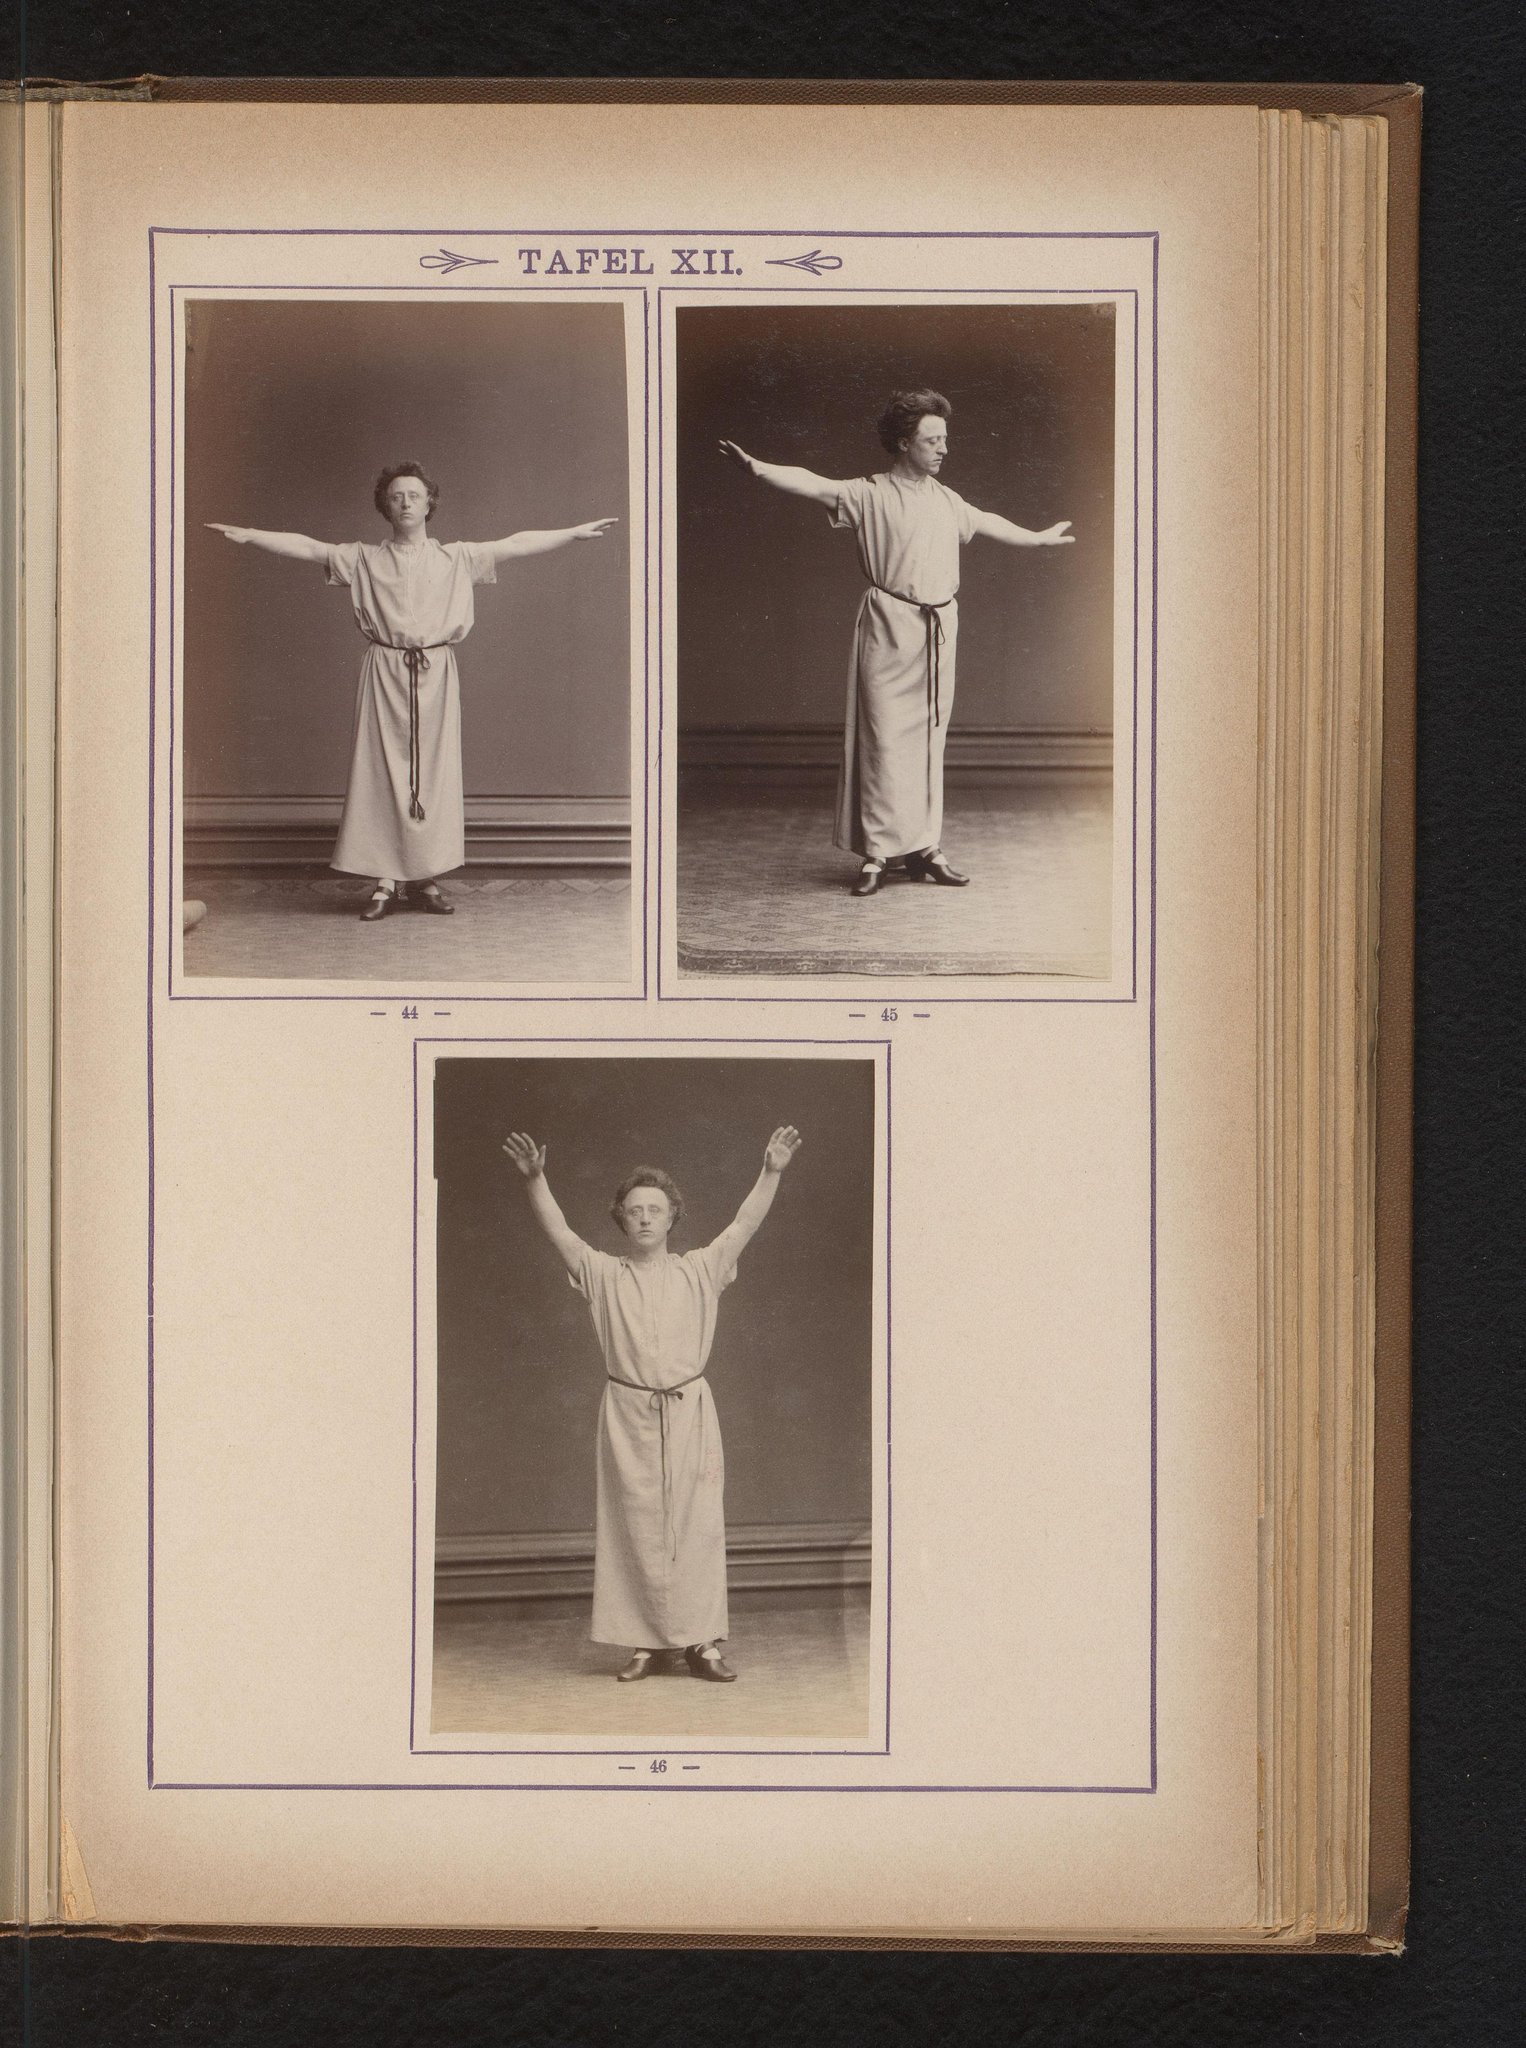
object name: page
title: Drie portretten van een man in verschillende poses met gestrekte armen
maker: nicola tonger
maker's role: fotograaf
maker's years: 1846-1917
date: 1881-1886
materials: paper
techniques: albumen print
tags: gesture-language, arm stretched sidewards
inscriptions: number: ‘TAFEL XII.’, number: ‘44 - 46’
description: Foto op drieëntwintigste ongenummerde pagina na pagina 6.